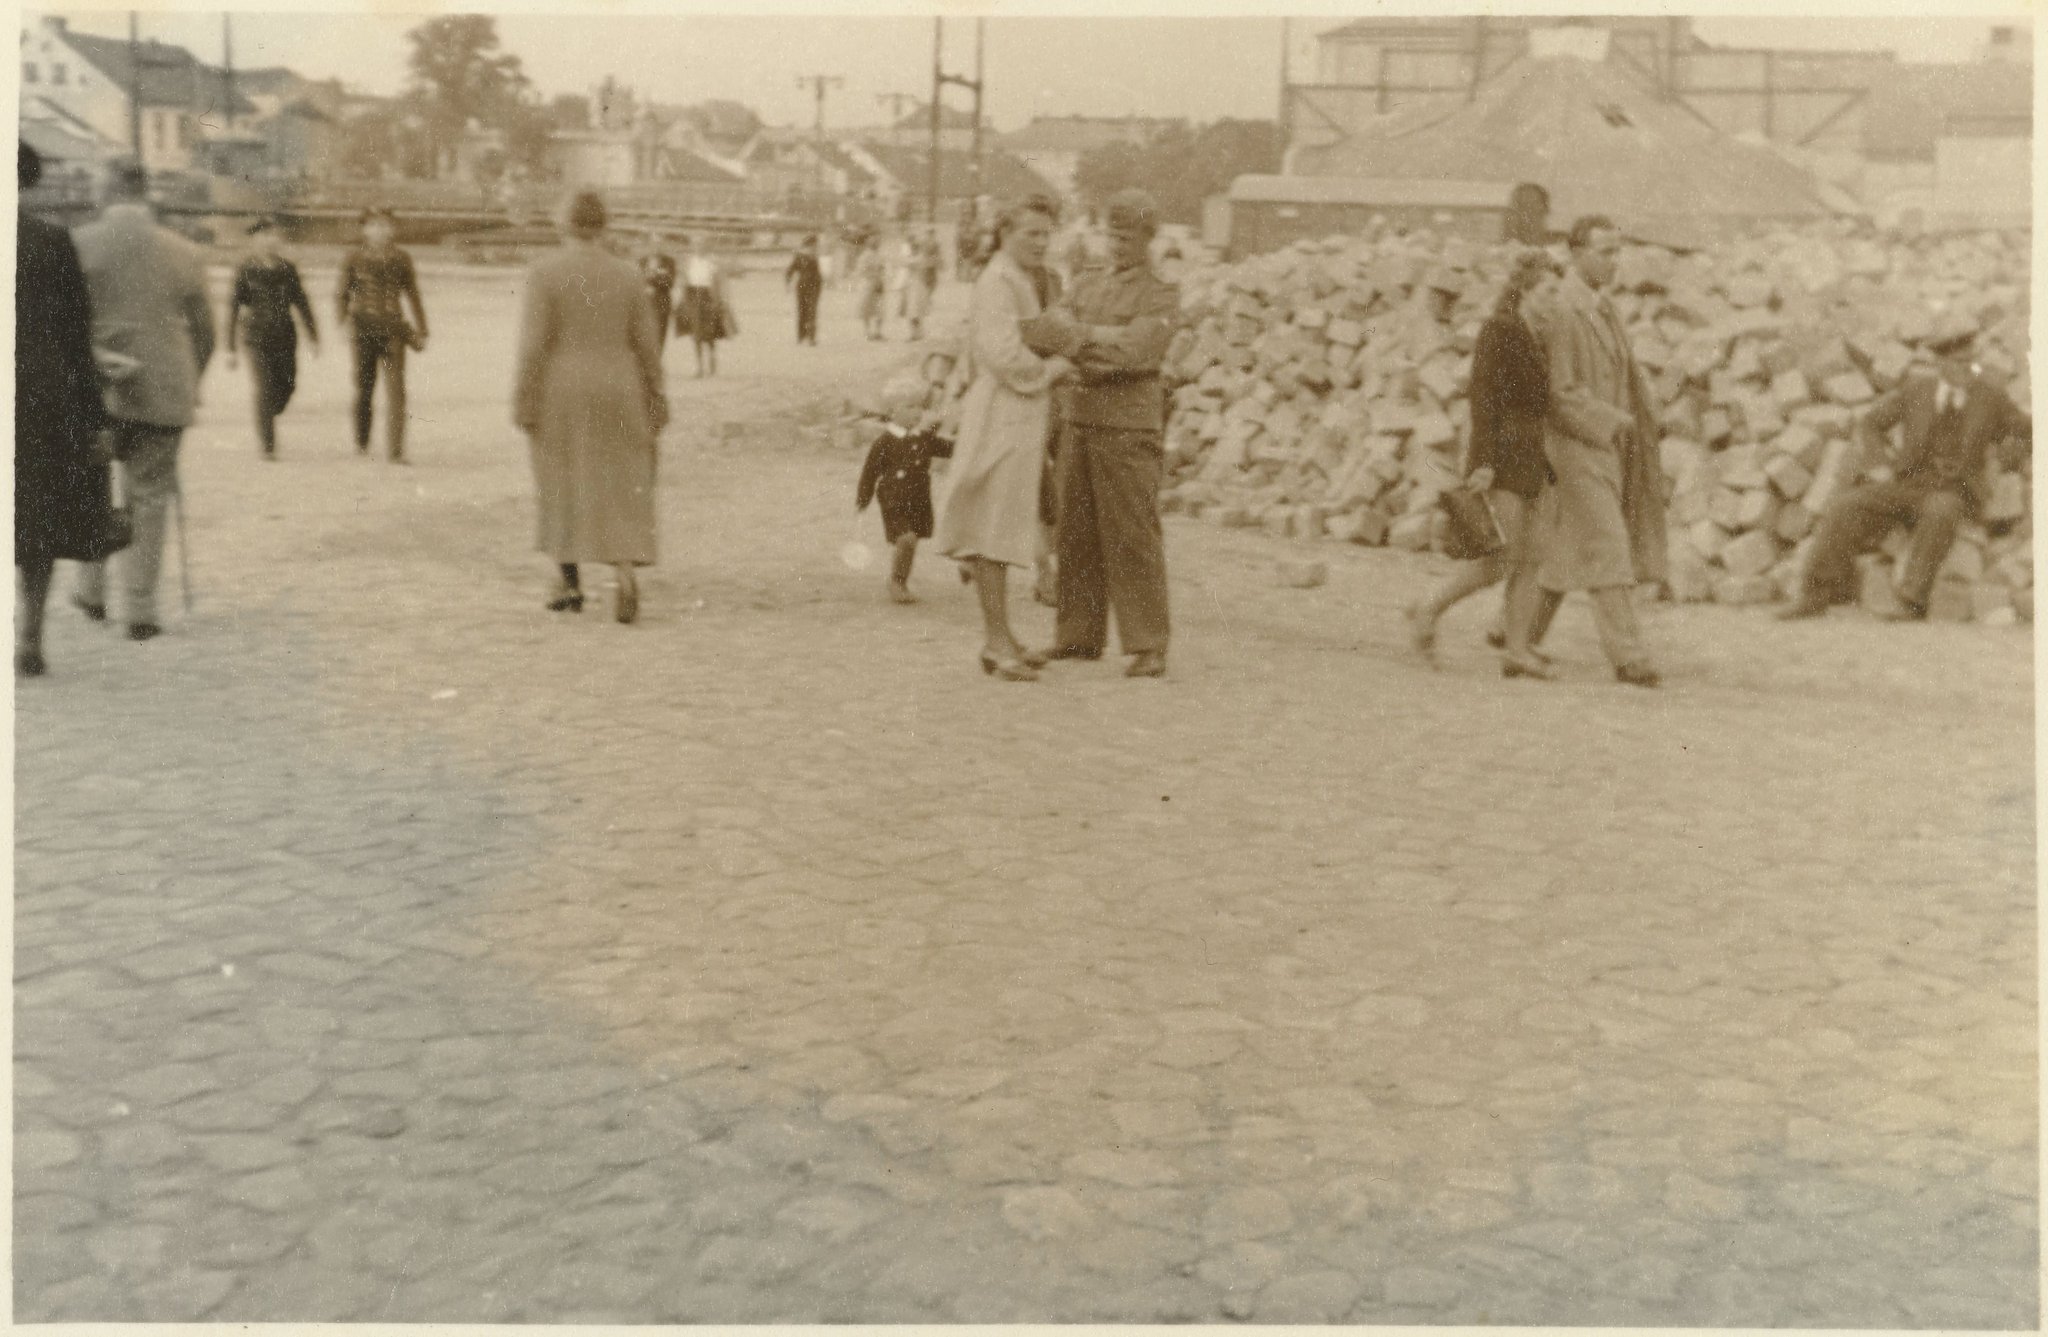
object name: photograph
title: Een geruïneerd huis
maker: Anonymous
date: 1940-1945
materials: photographic support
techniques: gelatin silver print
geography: germany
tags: netherlands, germany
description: Burgers en soldaten lopen op straat langs een geruïneerd huis. Foto behorend bij album 'Kriegserinnerungen'.